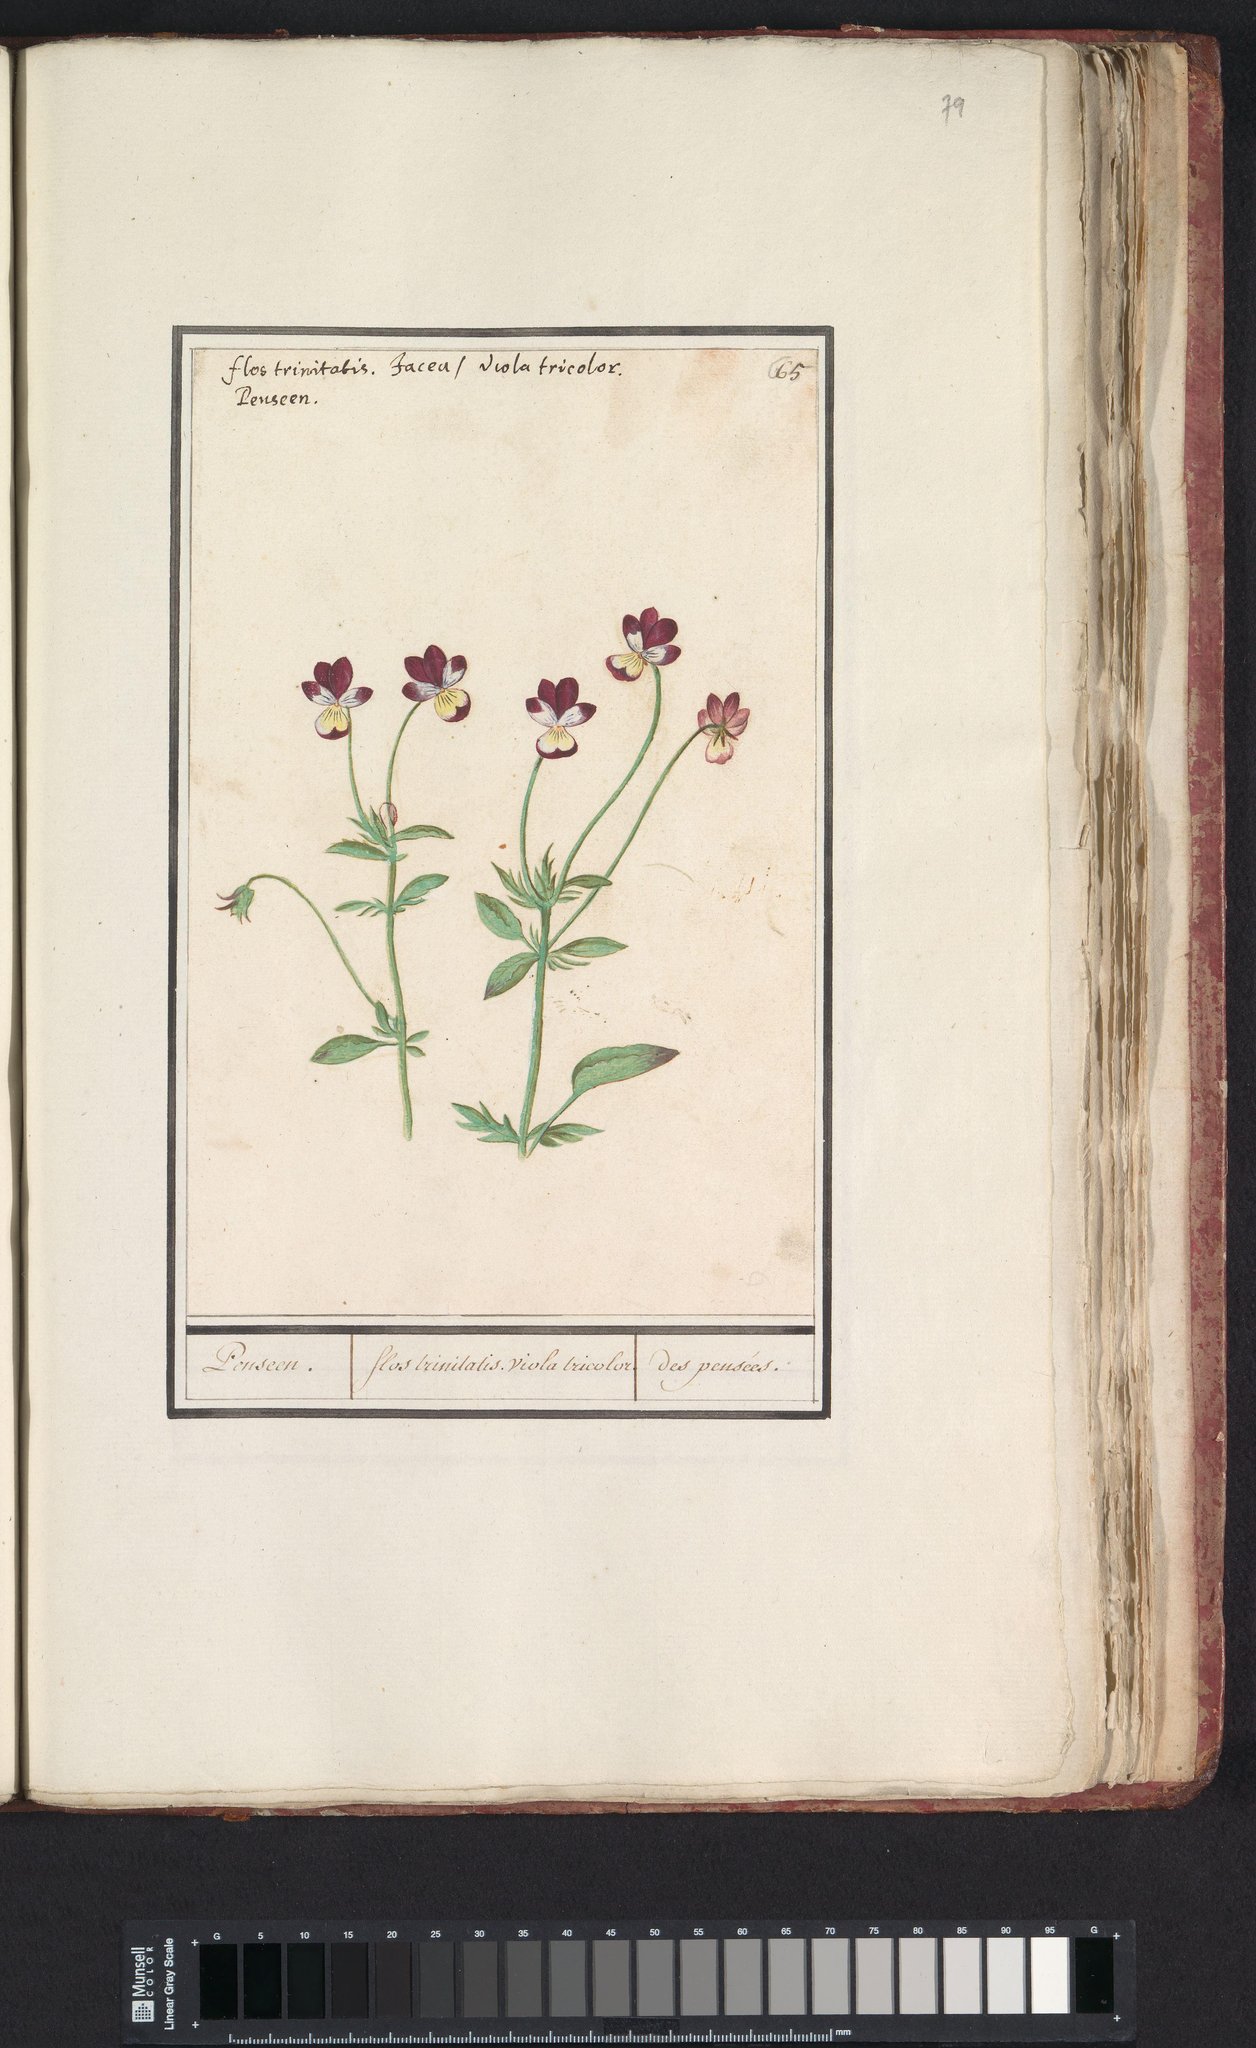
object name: drawing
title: Driekleurig viooltje (Viola tricolor)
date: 1596-1610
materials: chalk, paint, ink, paper, watercolor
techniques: brush, pen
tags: flowers: violet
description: Driekleurig viooltje. Genummerd rechtsboven: 65. Linksboven de Latijnse en Nederlandse naam. Onderdeel van het eerste album met tekeningen van bloemen en planten. Achtste van twaalf albums met tekeningen van dieren, vogels en planten bekend rond 1600, gemaakt in opdracht van keizer Rudolf II. Met toelichting in Nederlands, Latijn en Frans.